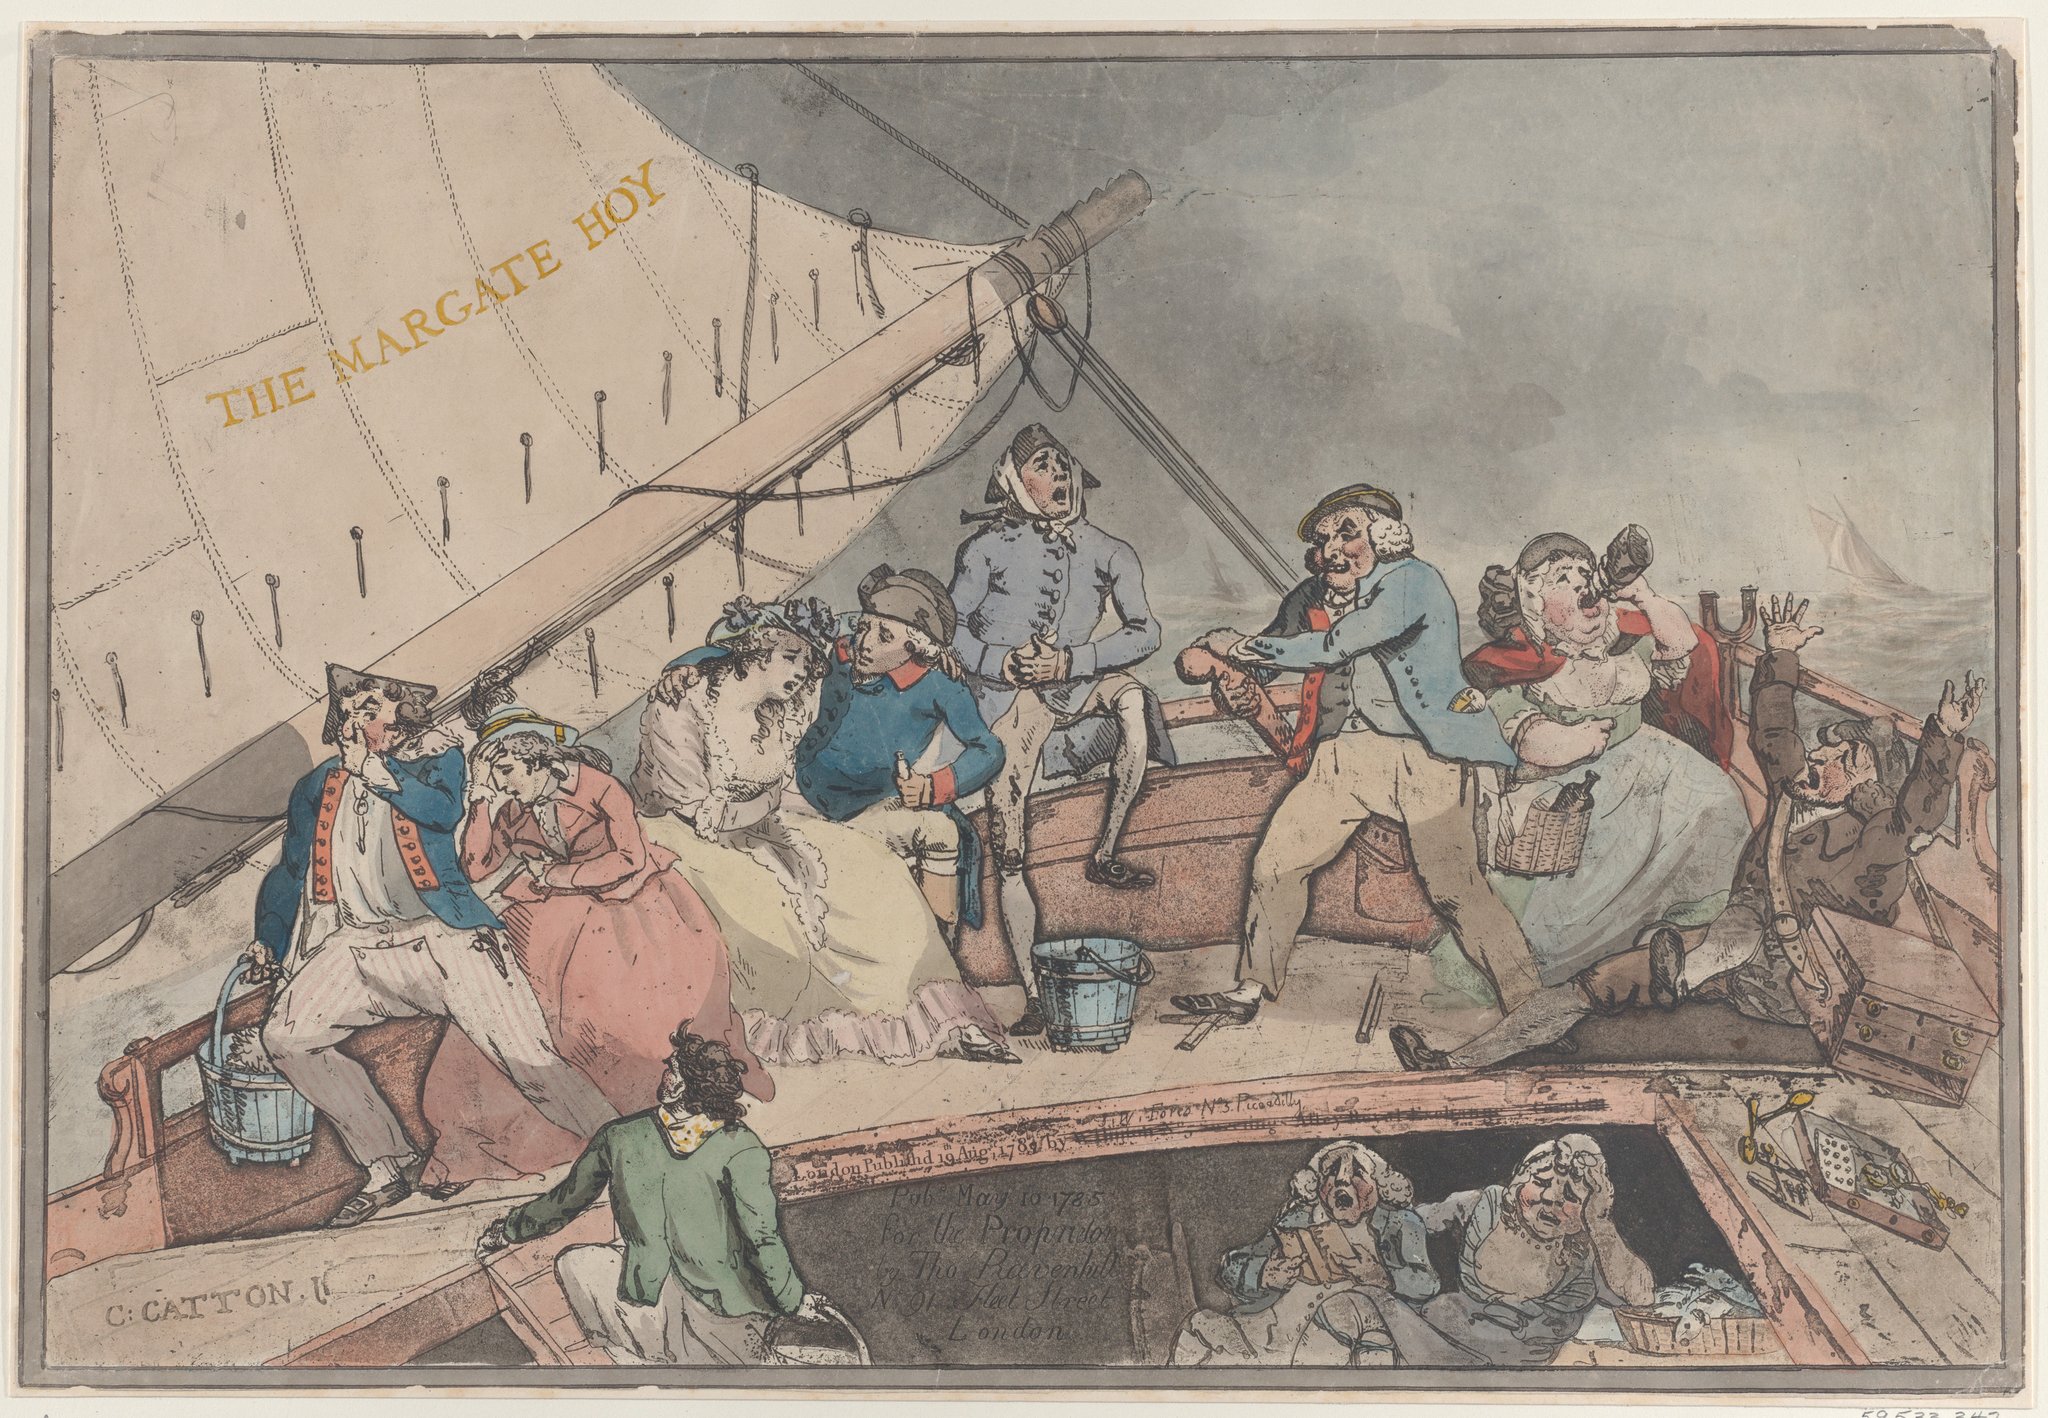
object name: print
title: The Margate Hoy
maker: charles catton, jr.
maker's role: artist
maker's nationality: british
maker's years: 1756-1819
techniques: aquatint, etching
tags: illness,men,women,boats